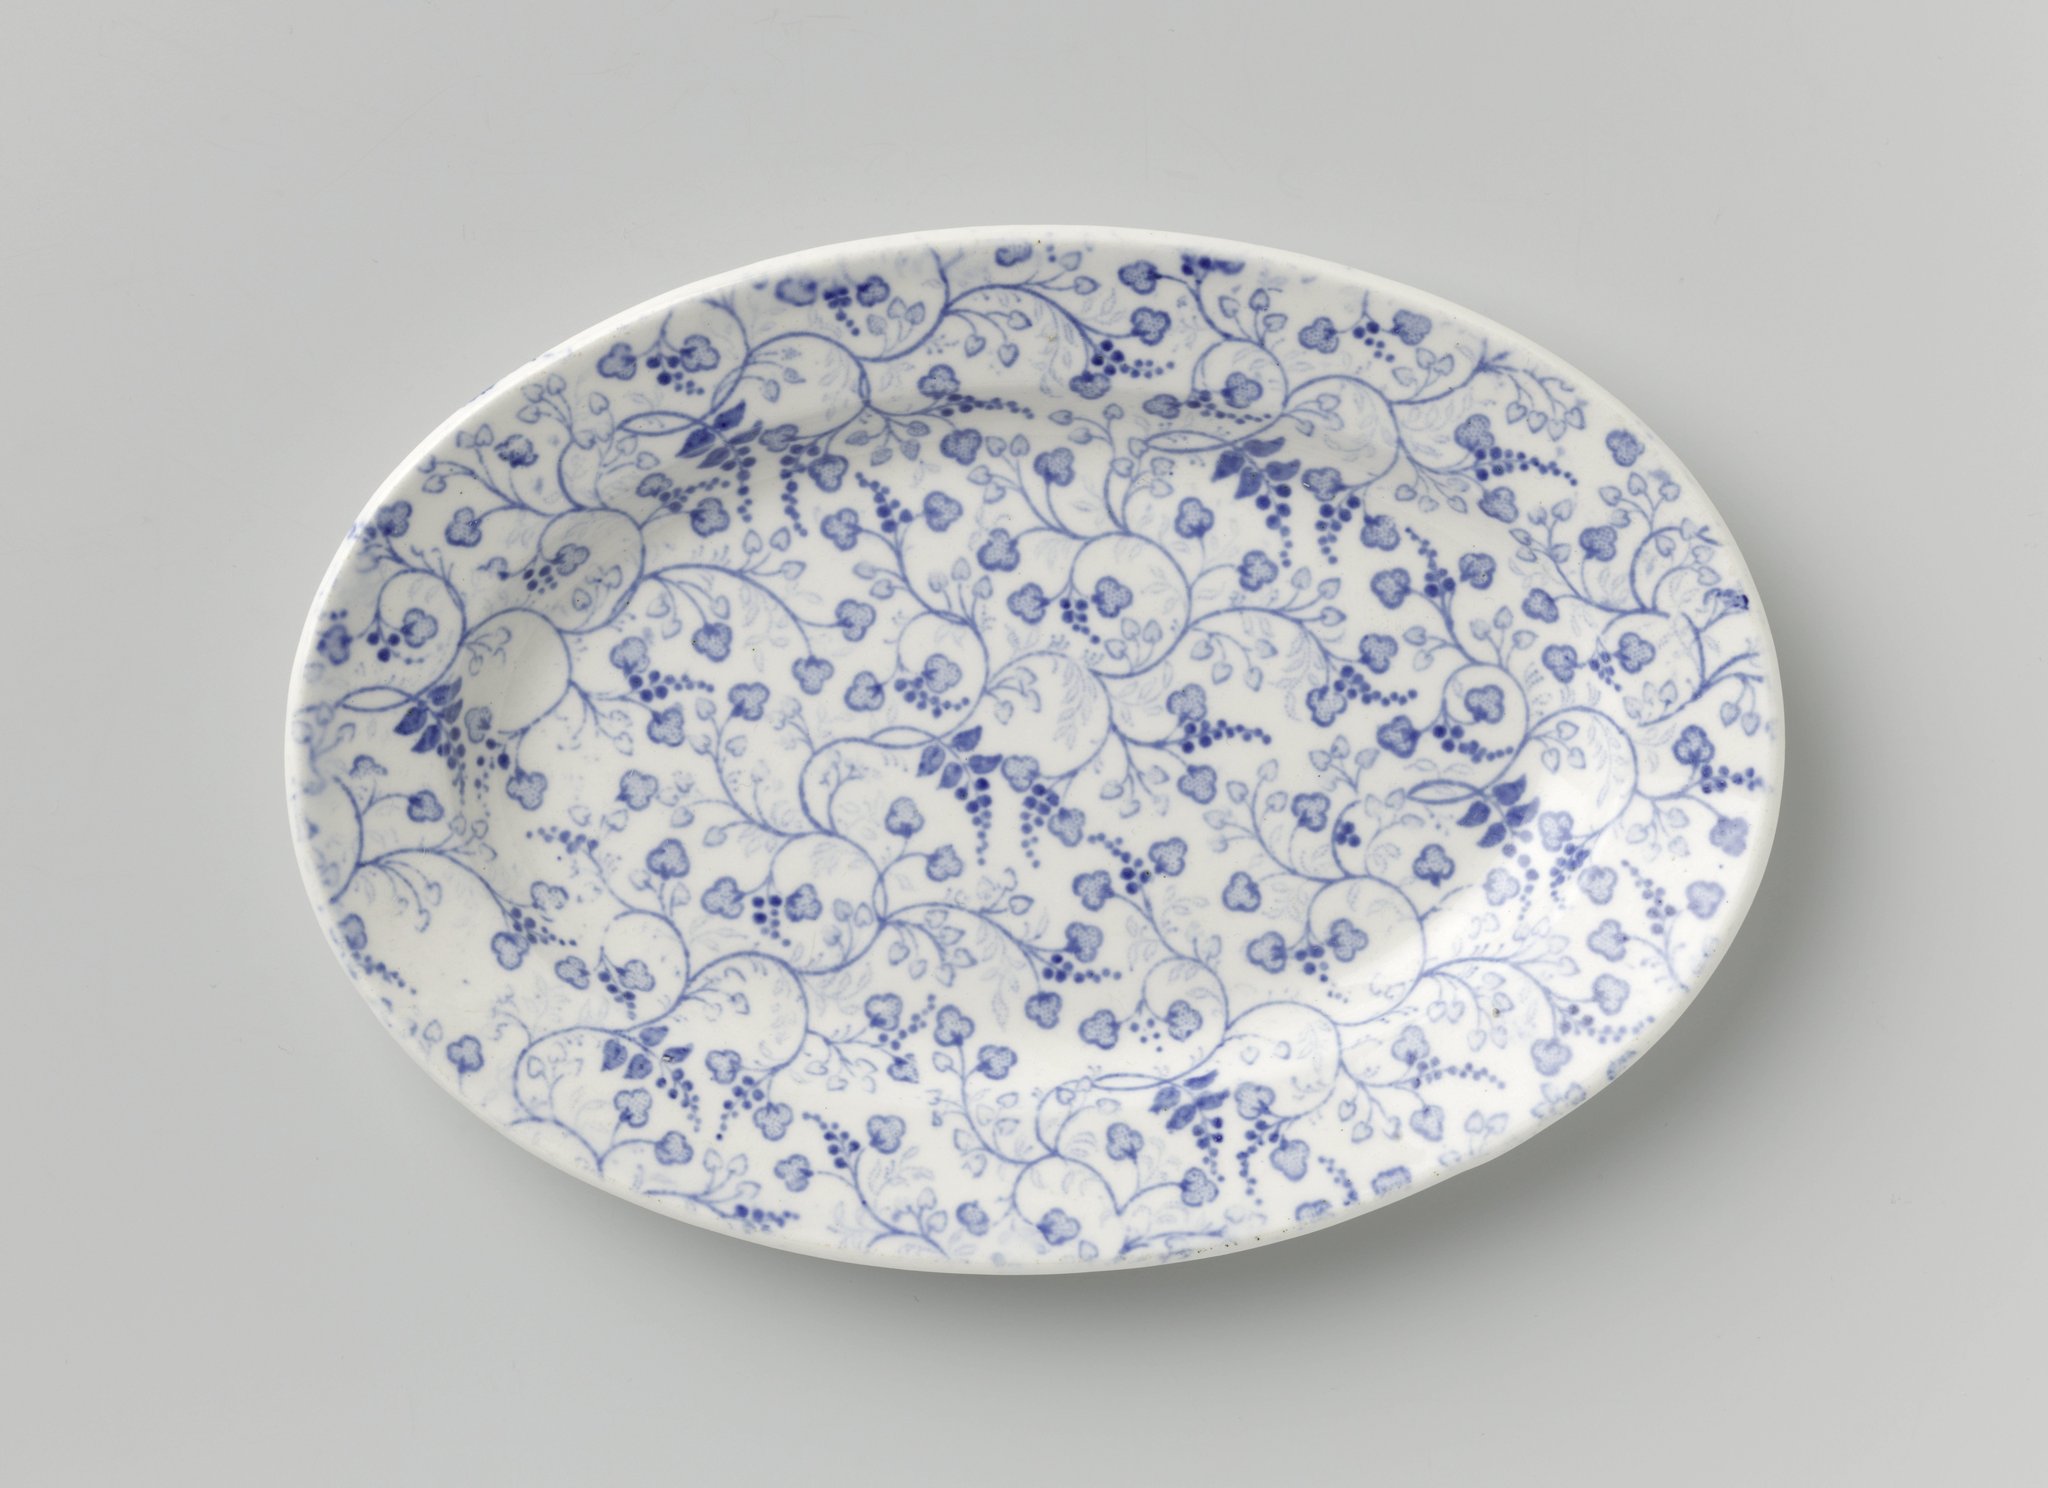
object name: dish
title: Schaal, ovaal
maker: petrus regout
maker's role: plateelbakker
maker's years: 1801-1879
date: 1867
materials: creamware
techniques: transfer decoration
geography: maastricht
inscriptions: check stamp: ‘PR 17 1’, mark: ‘PARSEME No 3 7 67’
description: Schaal van aardewerk, ovaal, met blauw doorlopend bloemendecor, behorend tot een kinderservies.